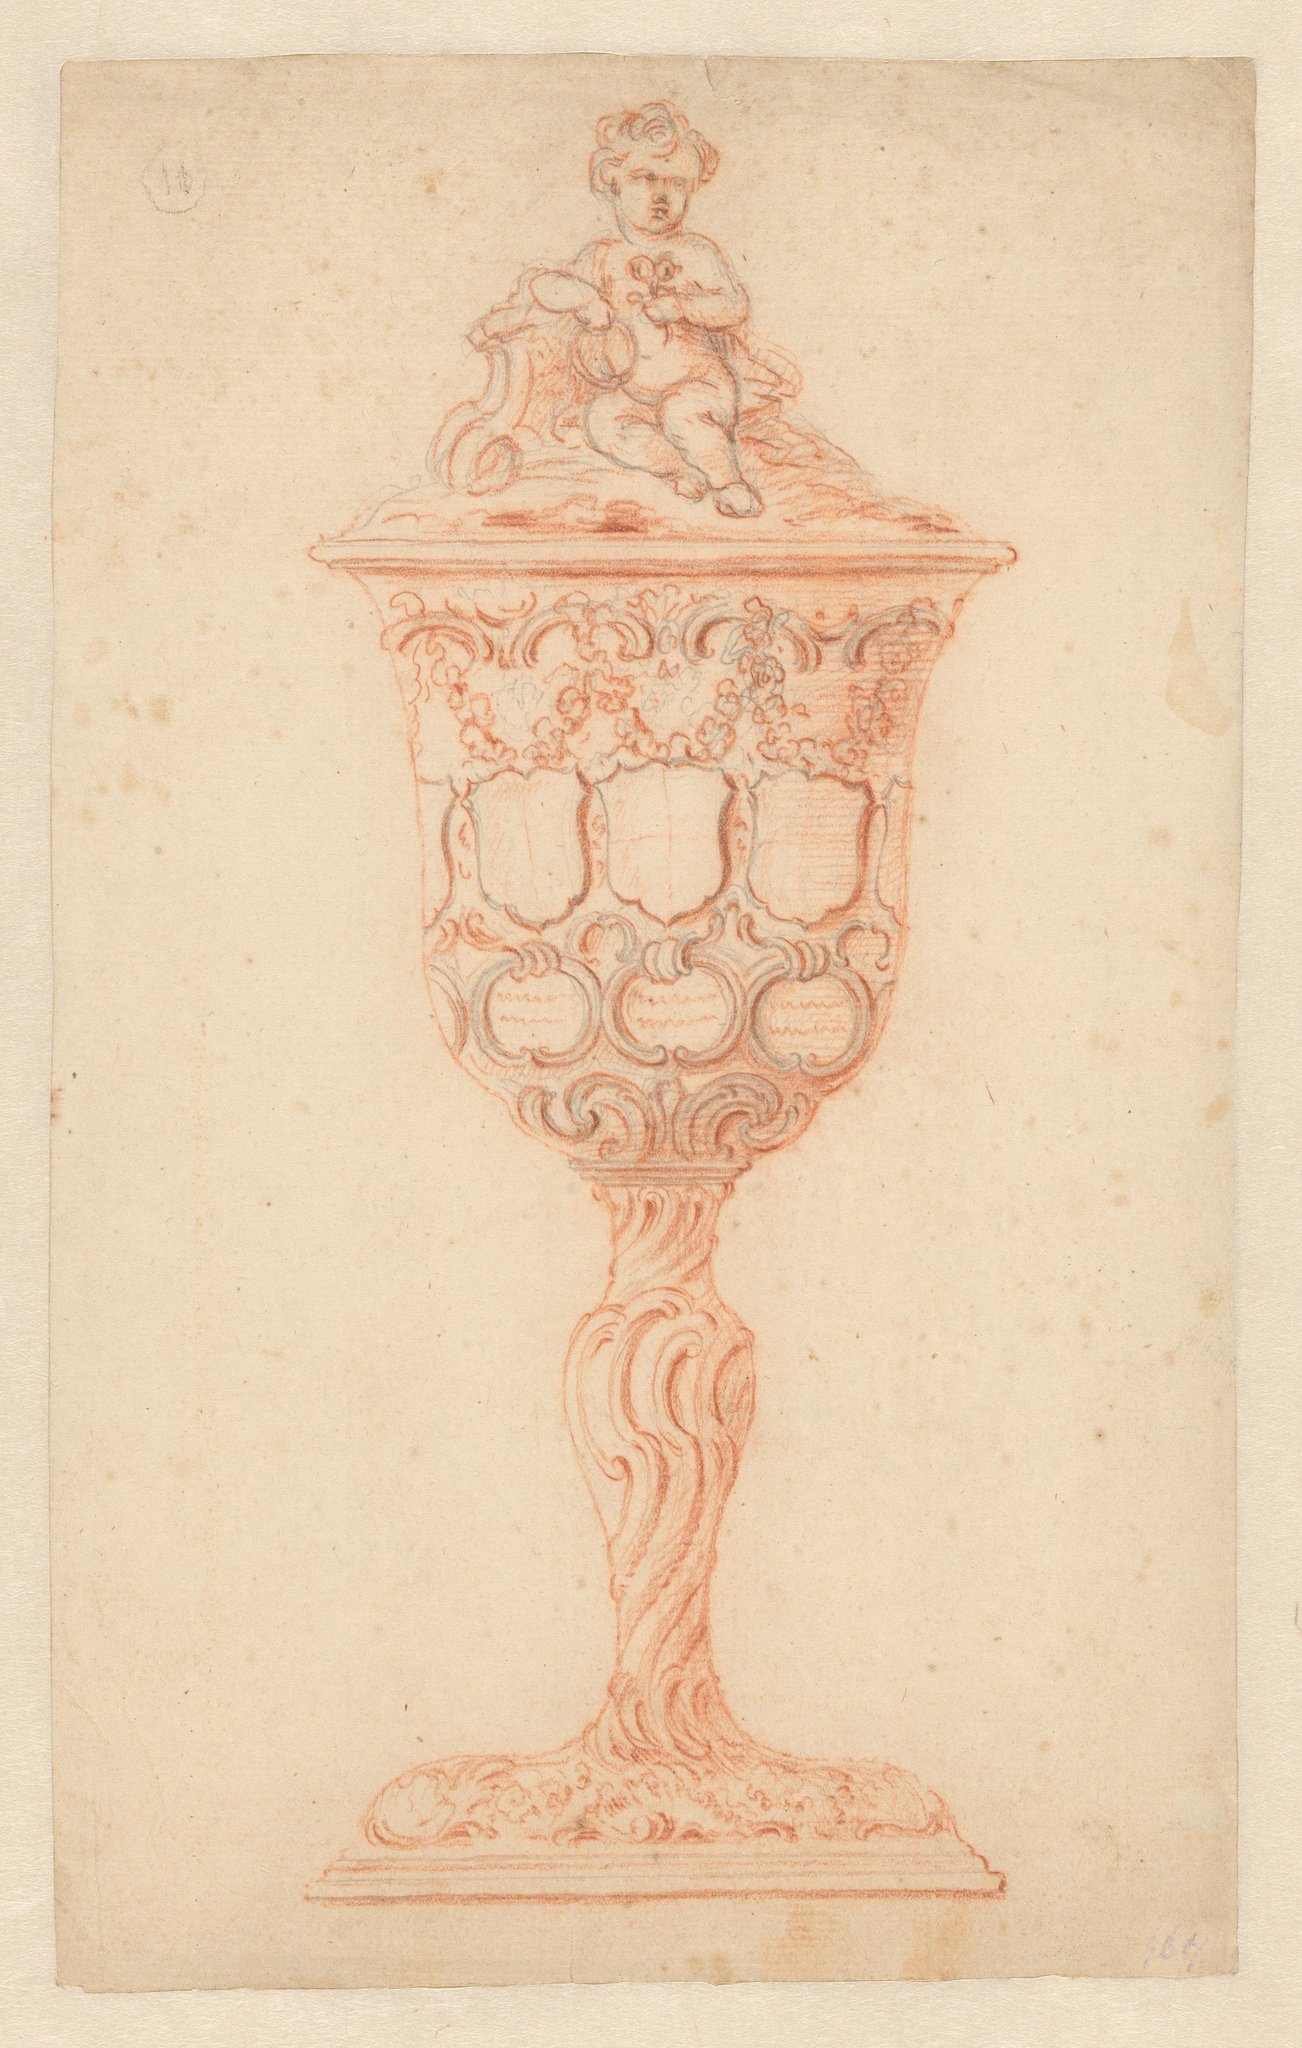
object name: design drawing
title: Ontwerp voor een dekselbokaal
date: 1750-1755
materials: chalk, paper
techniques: drawing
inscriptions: inscription: ‘964’, watermark: ‘PRO PATRIA’, inscription: ‘11’